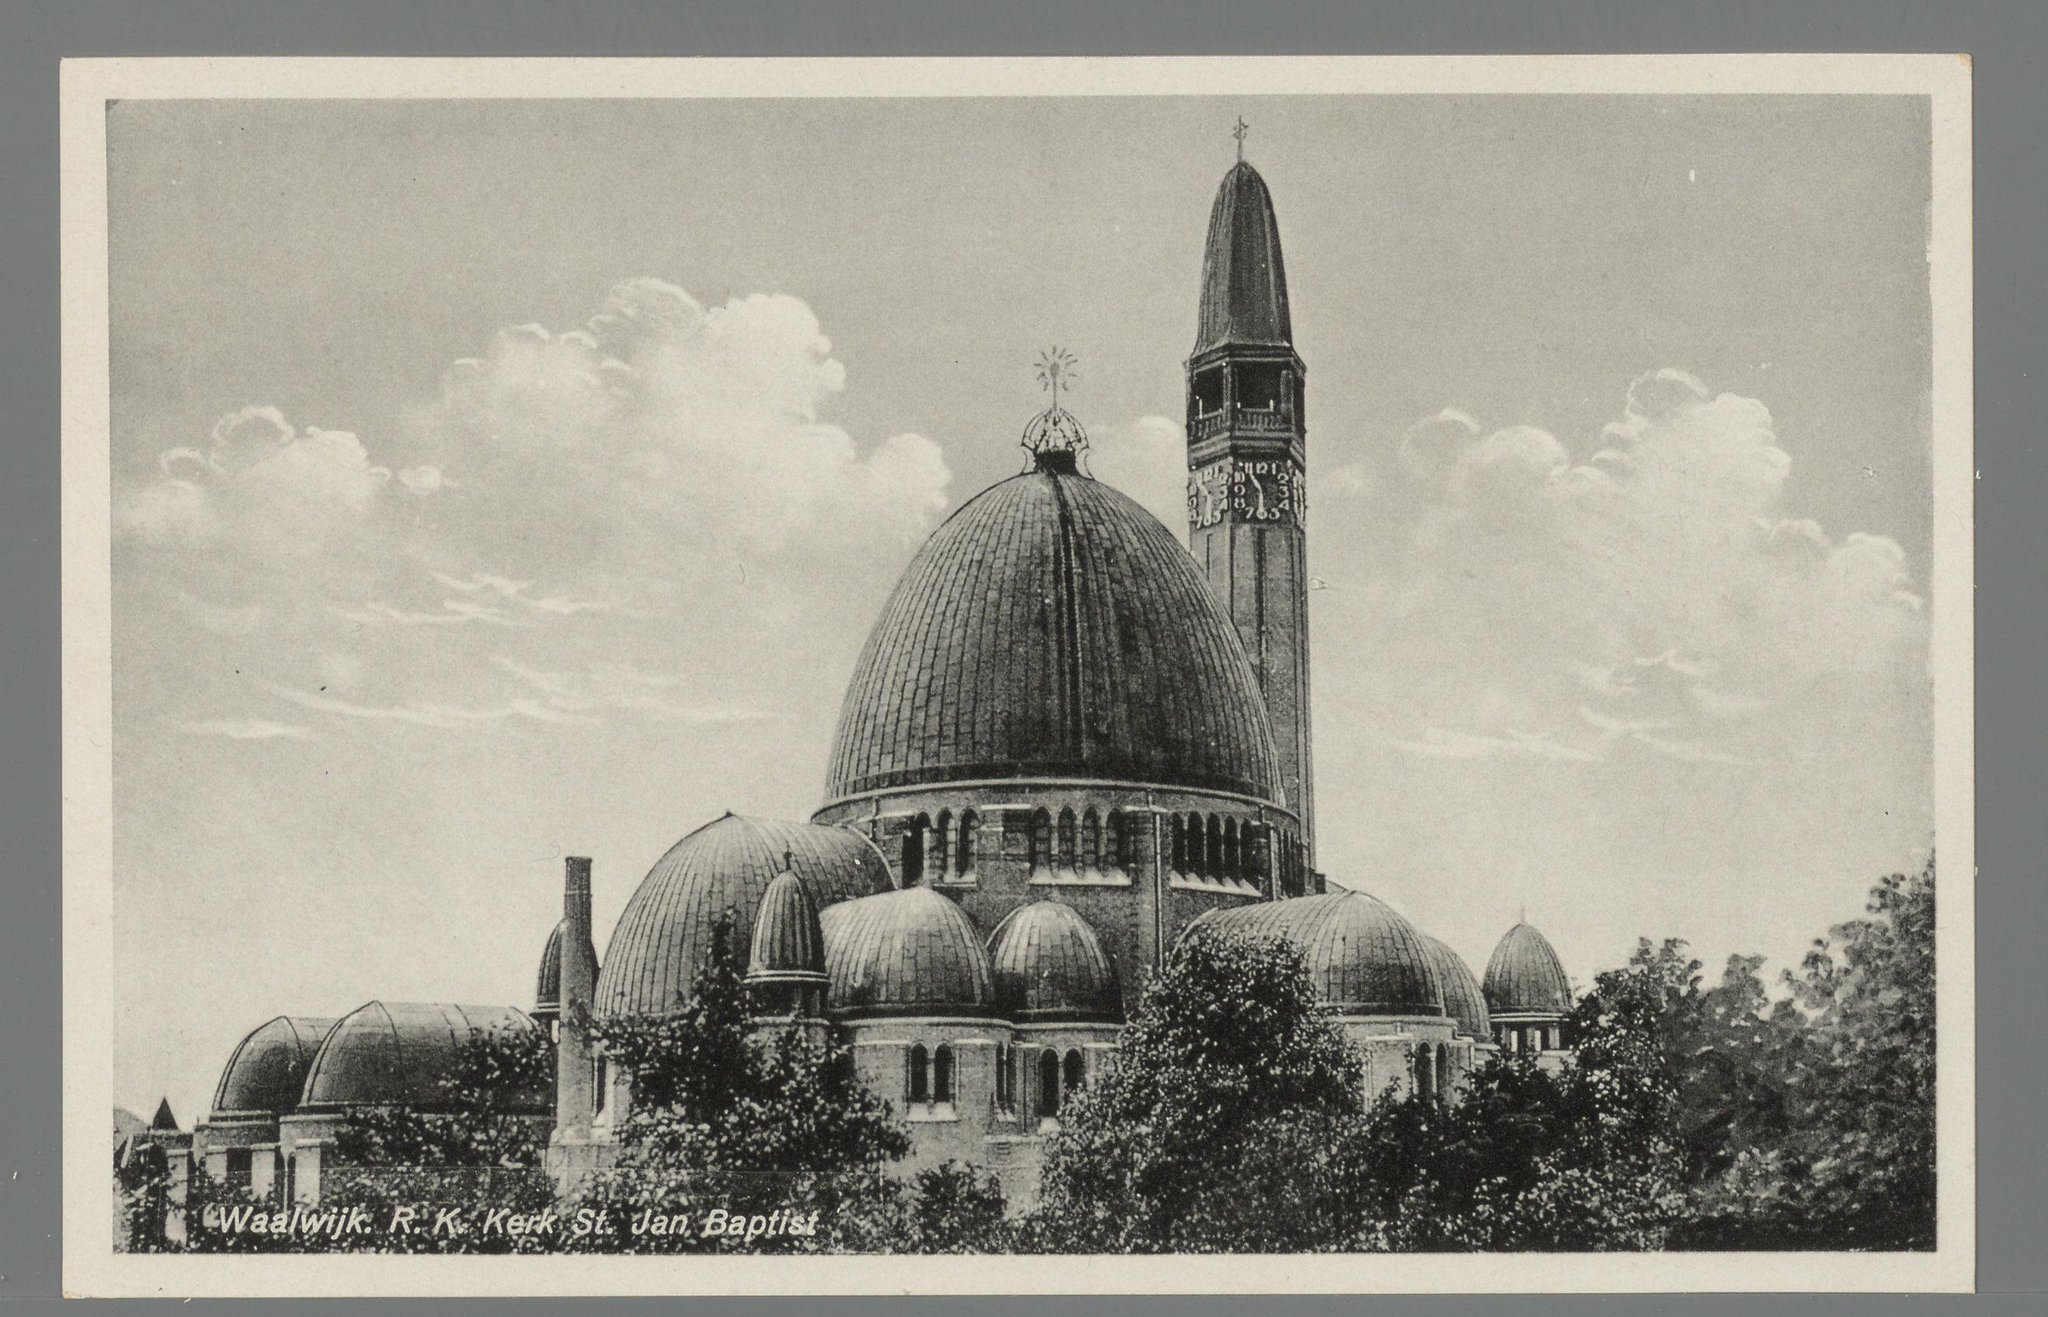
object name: photomechanical print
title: Waalwijk. R. K. Kerk St. Jan Baptist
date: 1939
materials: cardboard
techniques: photograph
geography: waalwijk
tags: church (exterior)